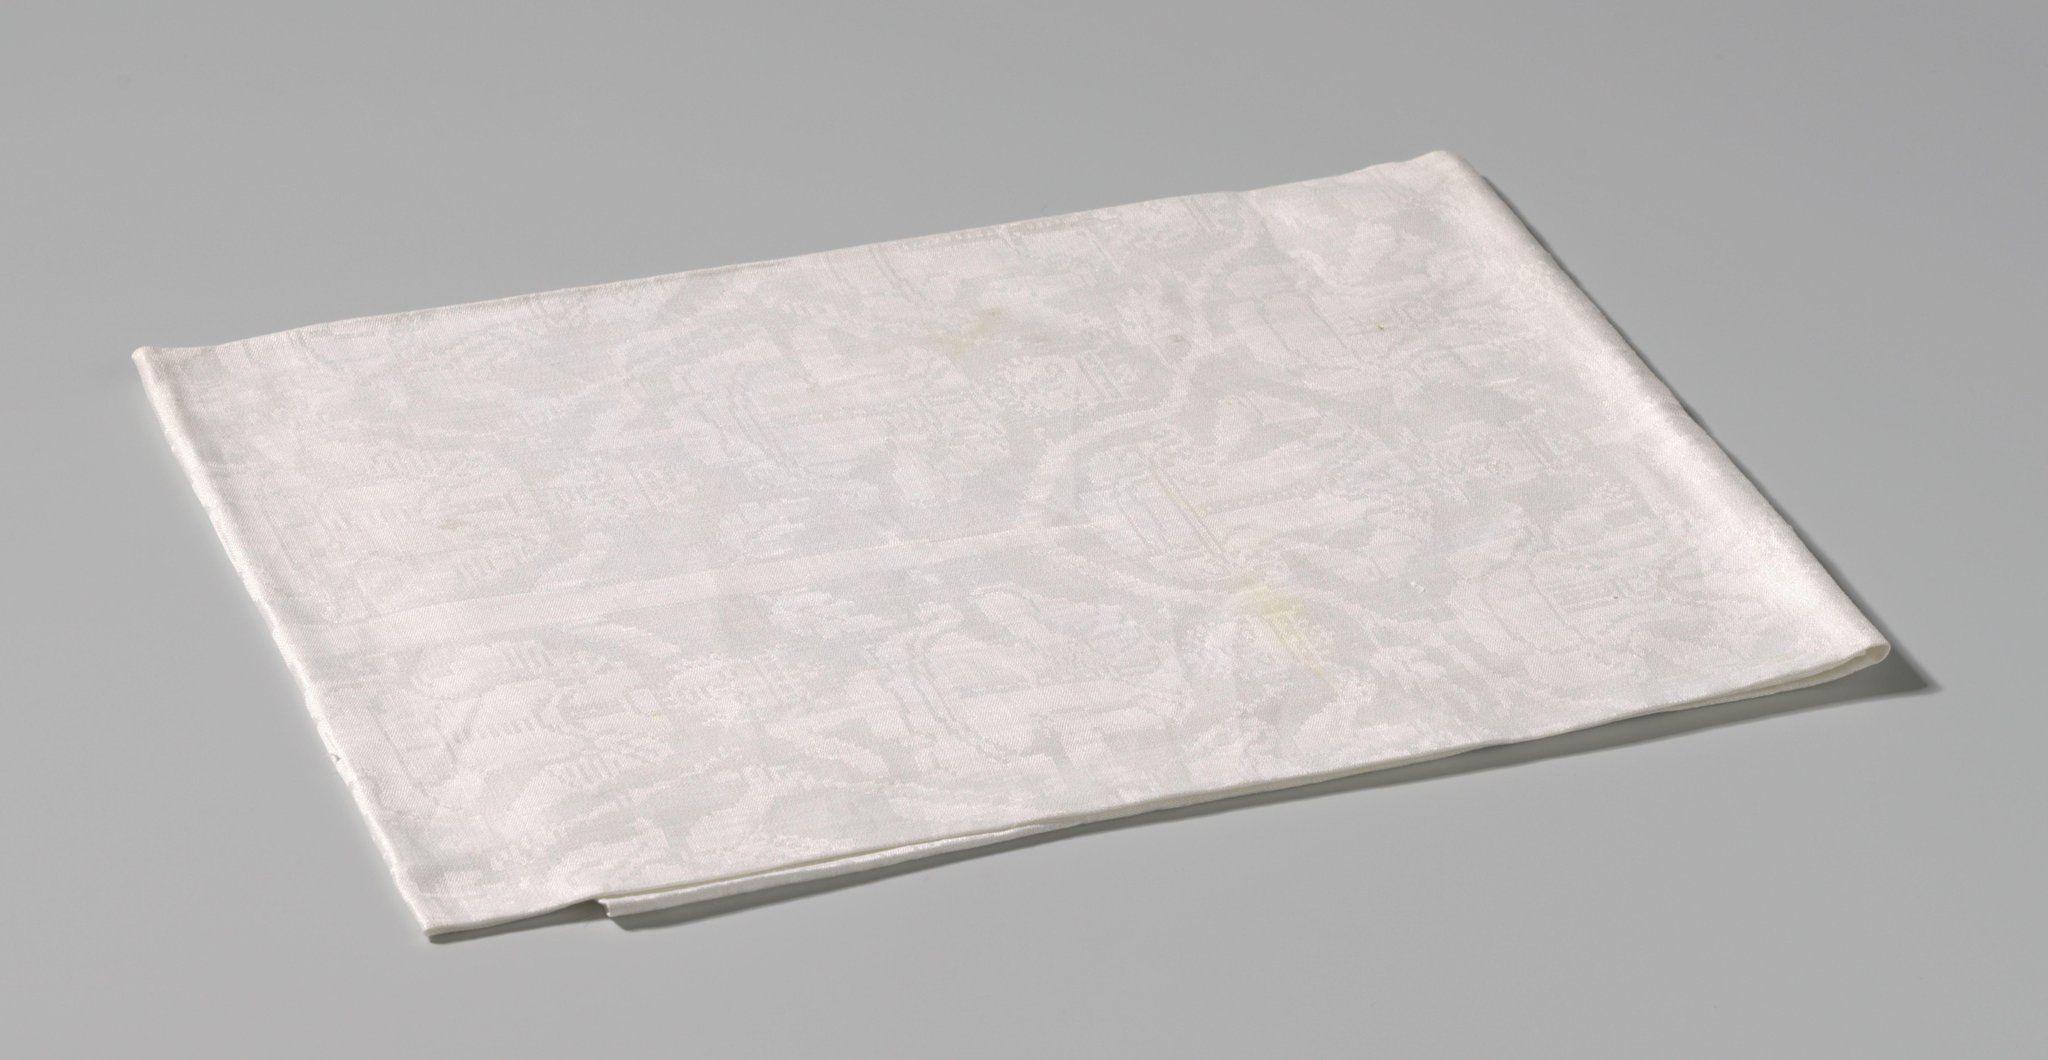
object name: napkin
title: Servet van linnendamast met de boom van Jesse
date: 1600-1625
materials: linen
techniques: damask, weave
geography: netherlands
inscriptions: mark: ‘KH 18’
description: Wit linnendamasten servet met de boom van Jesse. Het servet hoort bij vijf gelijke servetten (BK-1966-145-A t/m BK-1966-145-F).